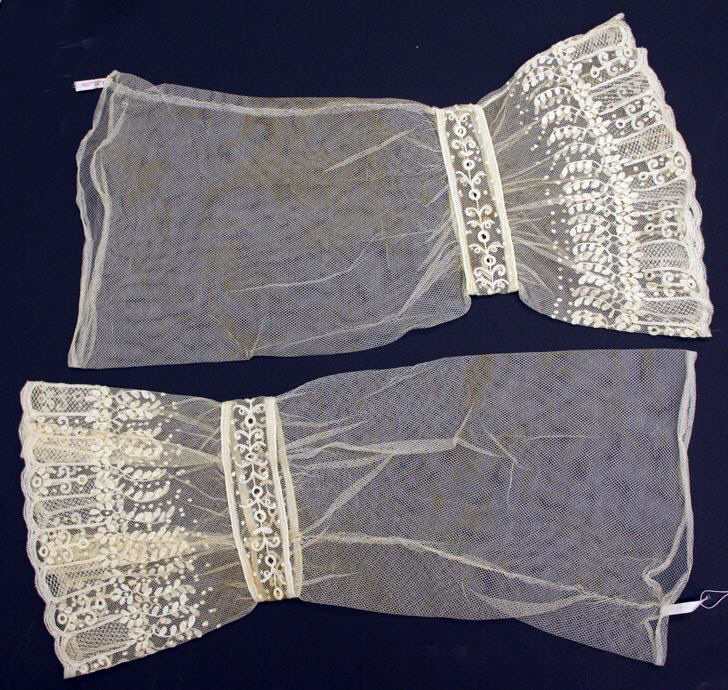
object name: undersleeves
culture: british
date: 1834-1866